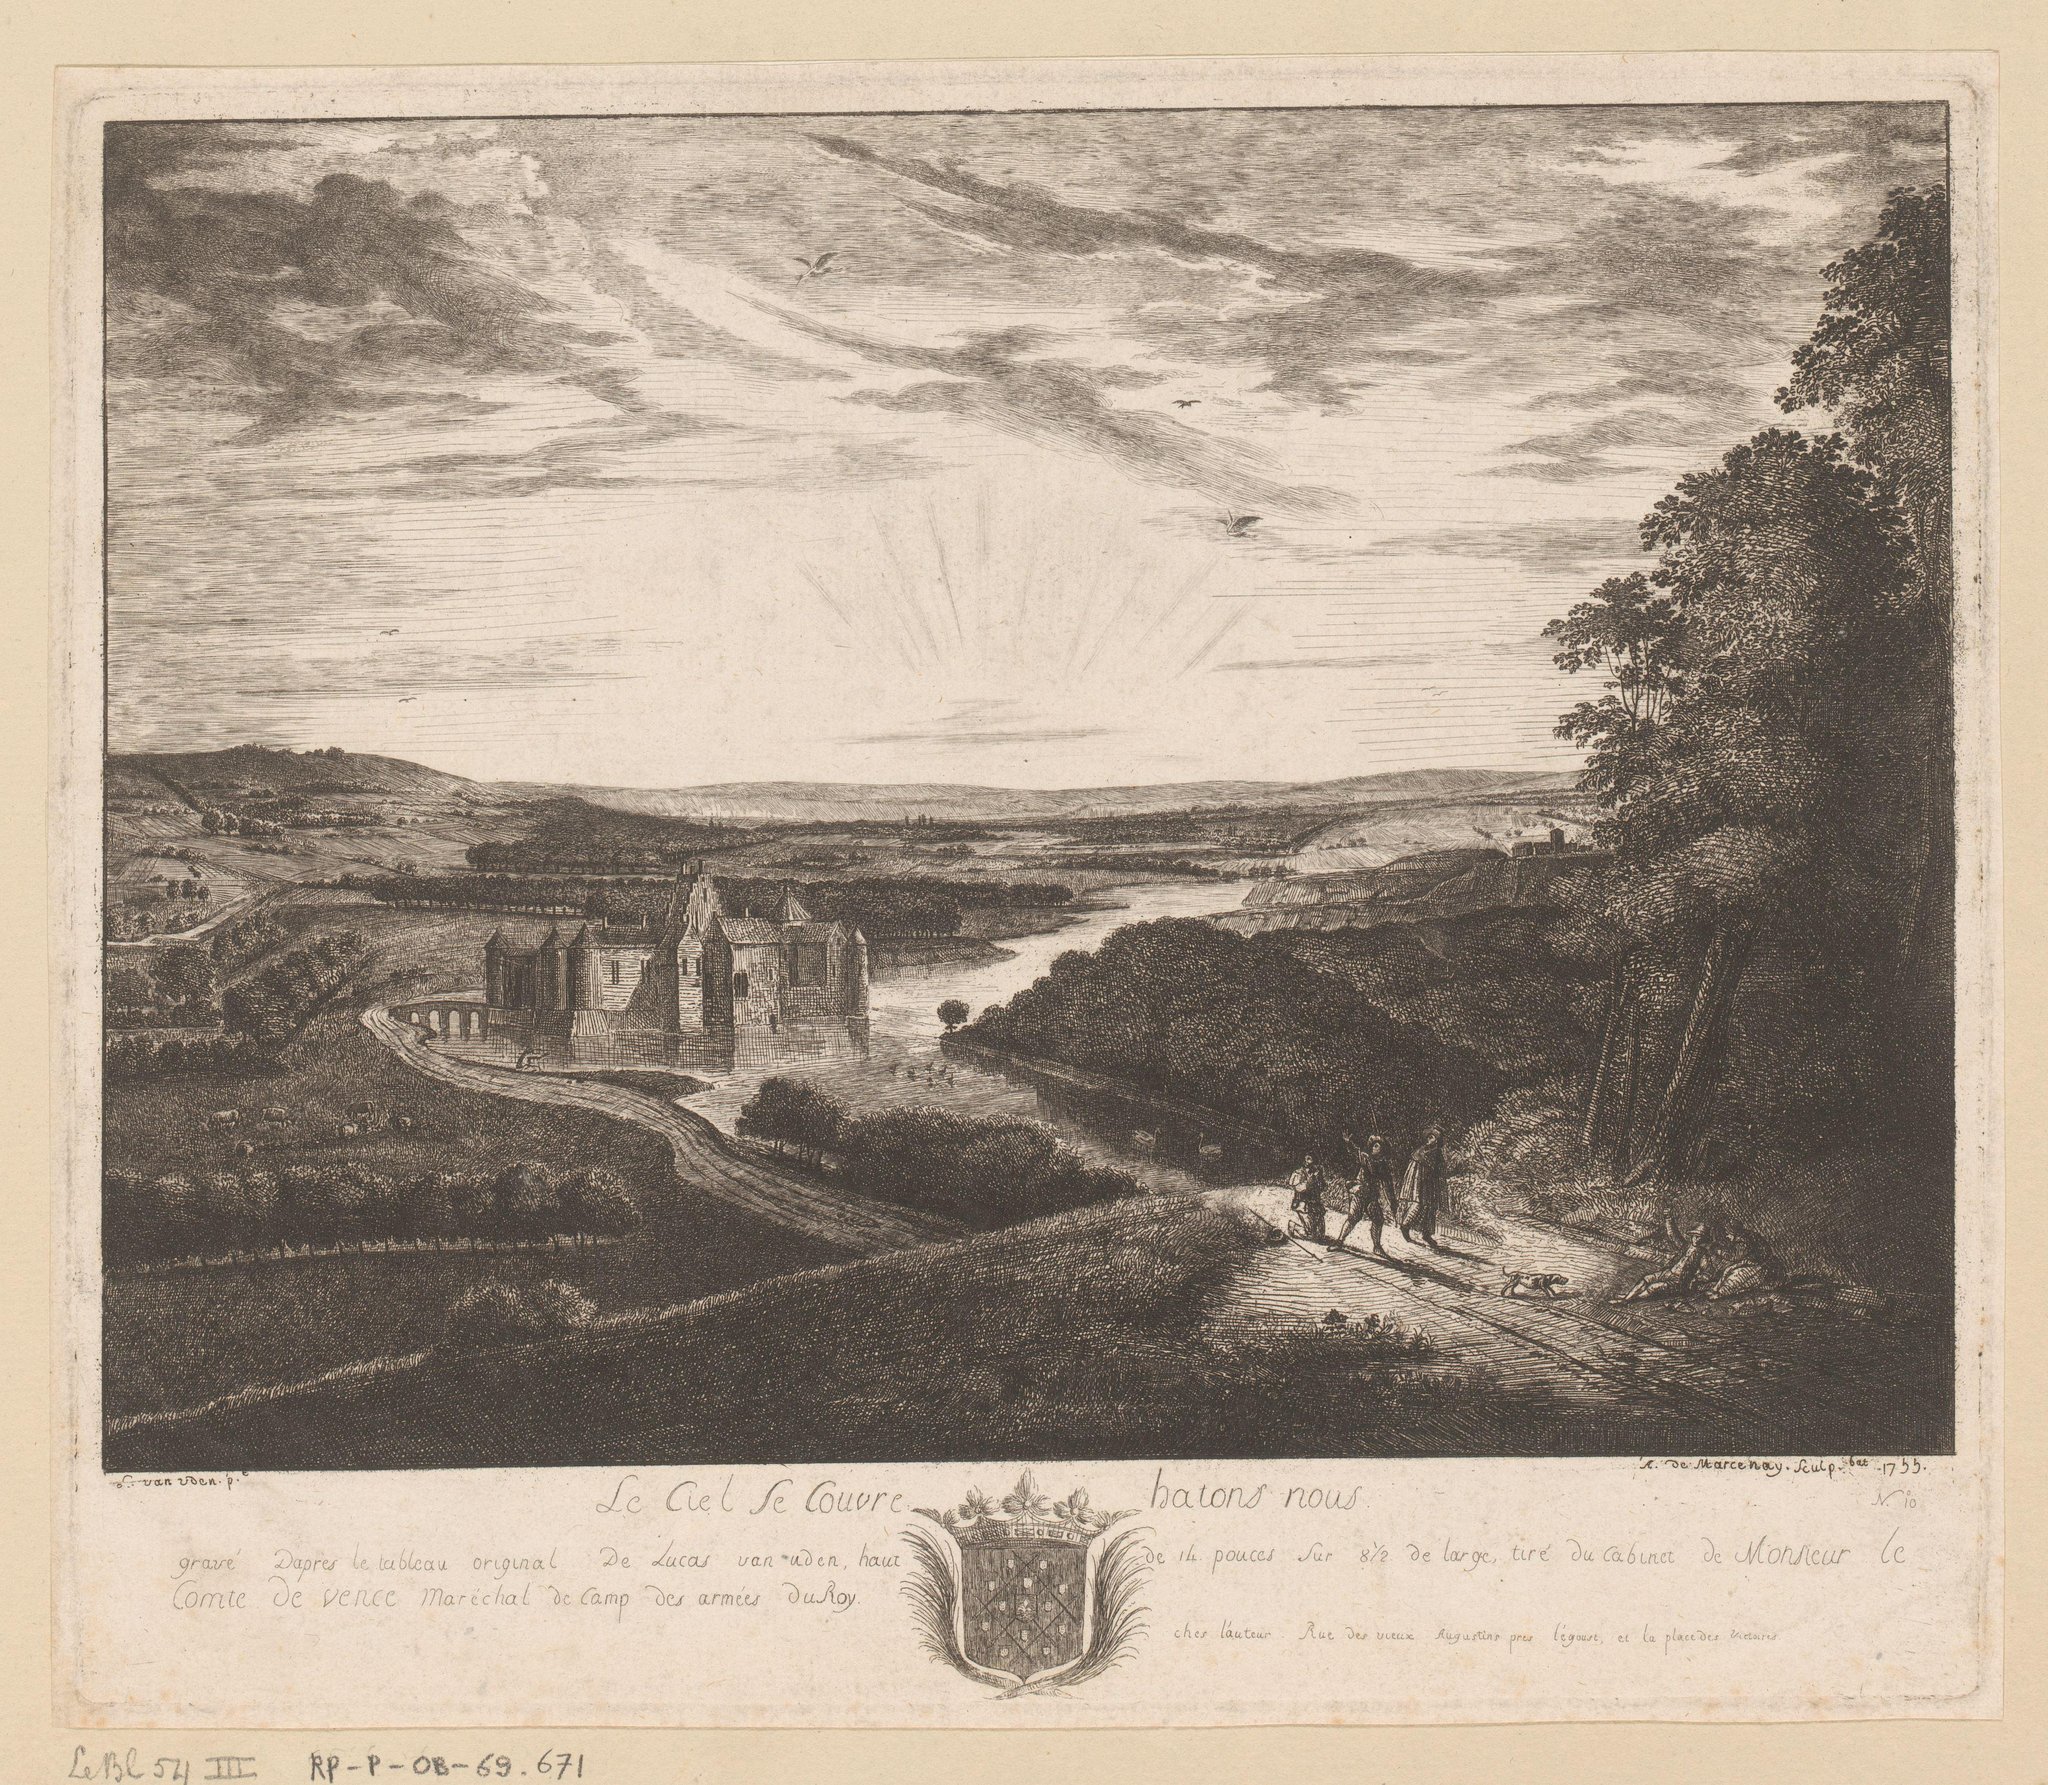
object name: print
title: Le Ciel se couvre, hâtons-nous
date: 1755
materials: paper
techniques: etching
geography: paris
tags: castle, river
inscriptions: collector's mark: Lugt 2228